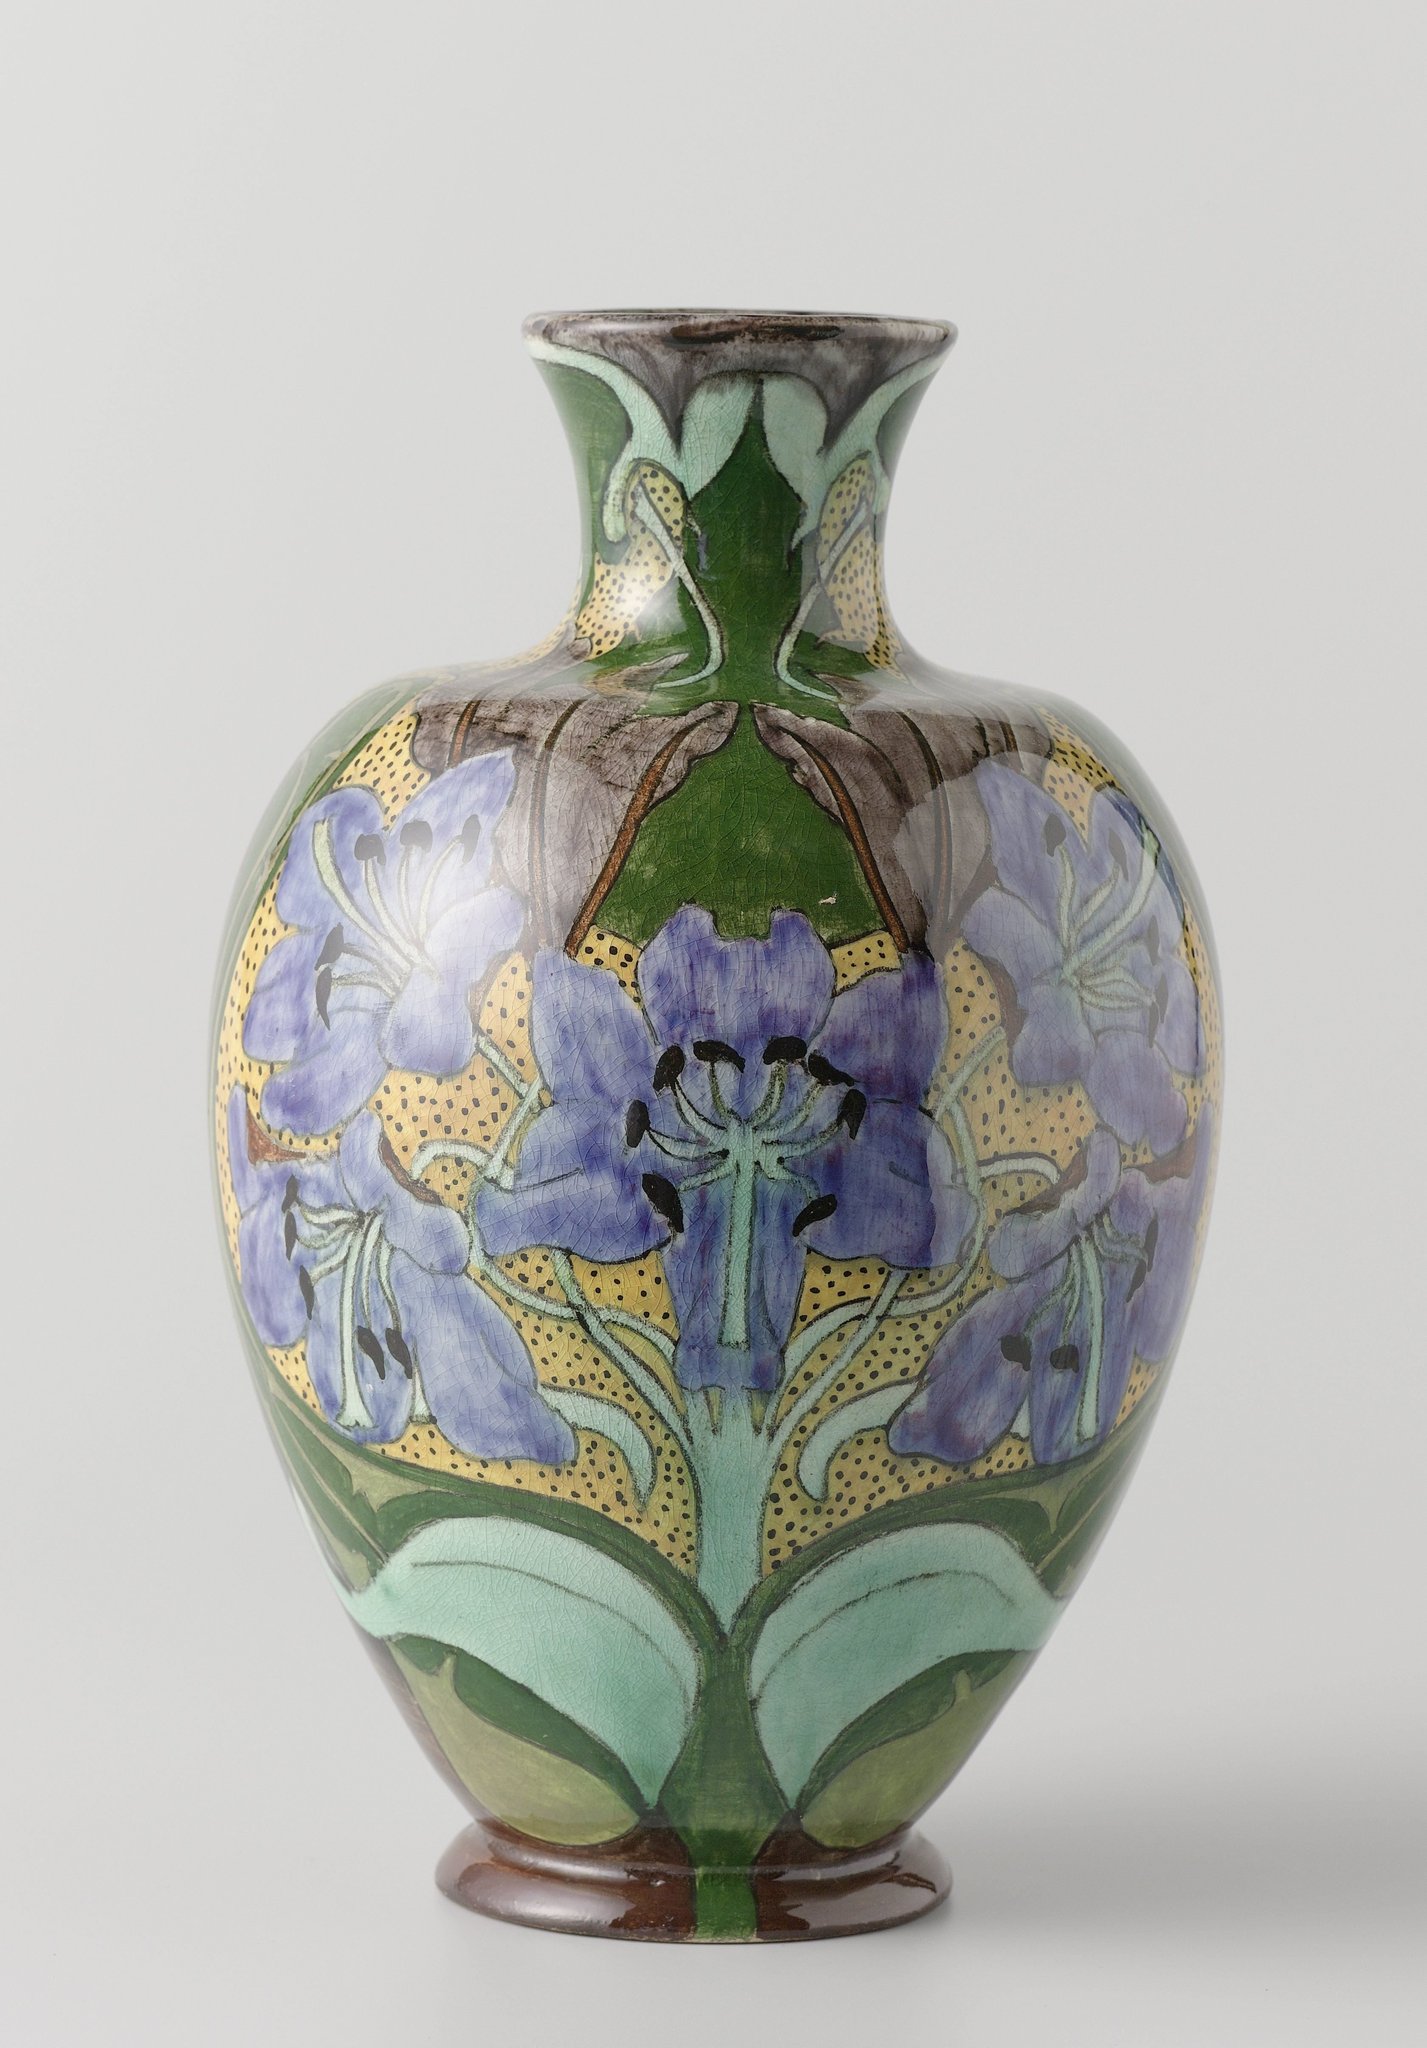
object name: vase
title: Vaas met symmetrisch geplaatste bloemen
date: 1895-1904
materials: earthenware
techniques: painted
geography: purmerend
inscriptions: mark: ‘502 waaronder monogram TH’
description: Two vases. Earthenware. Purmerend, c. 1898 - 1904, made by Firma Wed. N.S.A. Brantjes, decorated by T.H., factory under the direction of the .widow of N.S.A. Brantjes